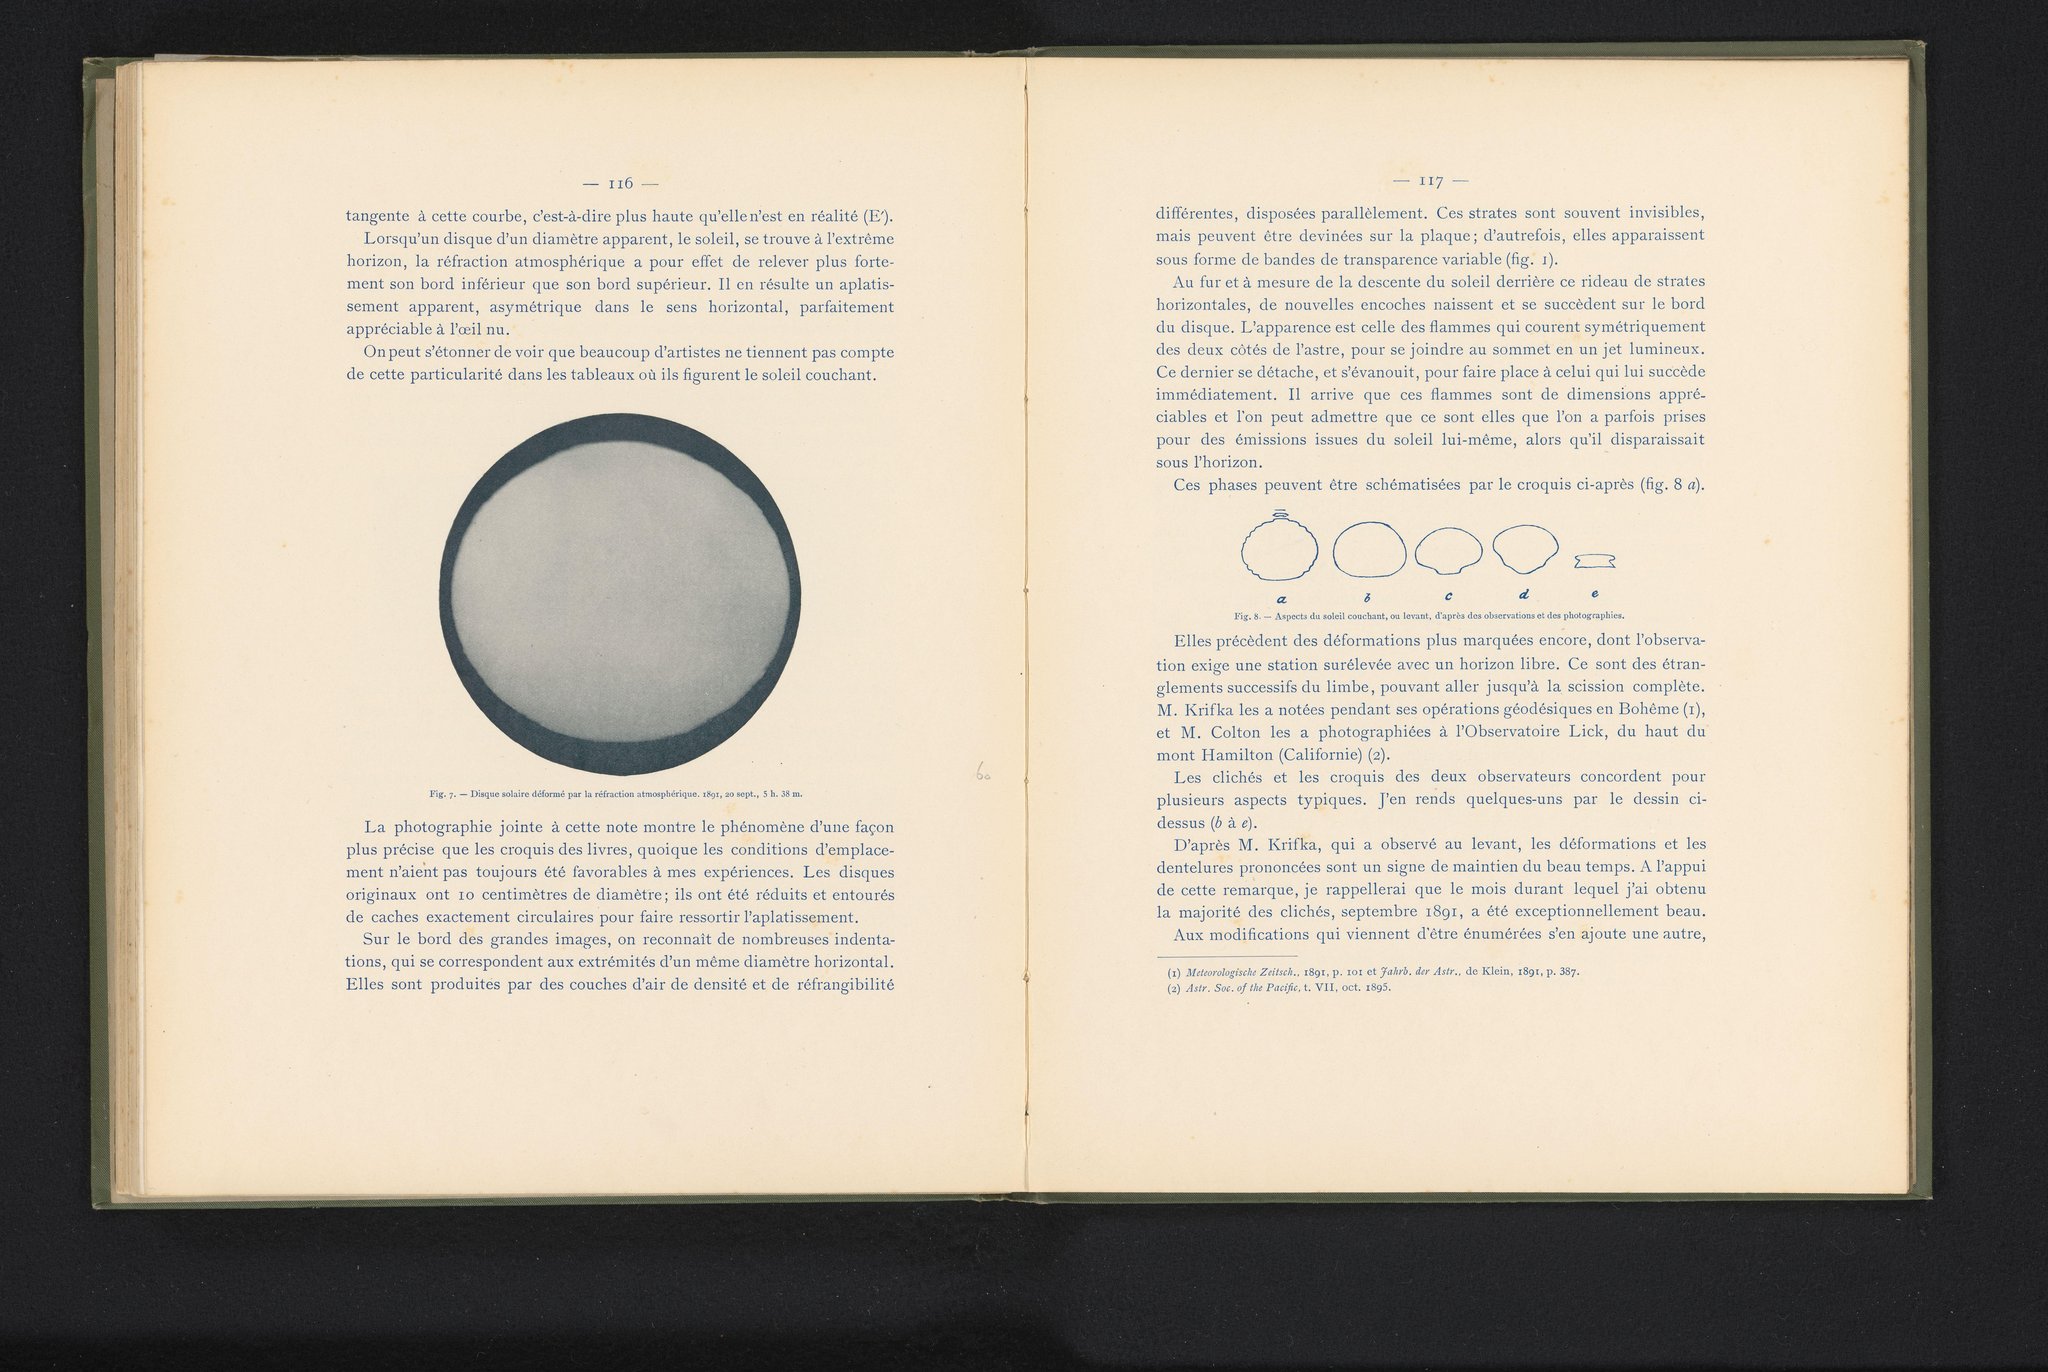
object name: photomechanical print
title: Vervorme zonneschijf door de atmospherische breking van het licht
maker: Anonymous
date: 1893-1898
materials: paper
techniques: autotype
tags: sun as celestial body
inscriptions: inscription: ‘Fig. 7. - Disque solaire déformé par la réfraction atmosphérique. 1891, 20 sept., 5 h. 38 m.’